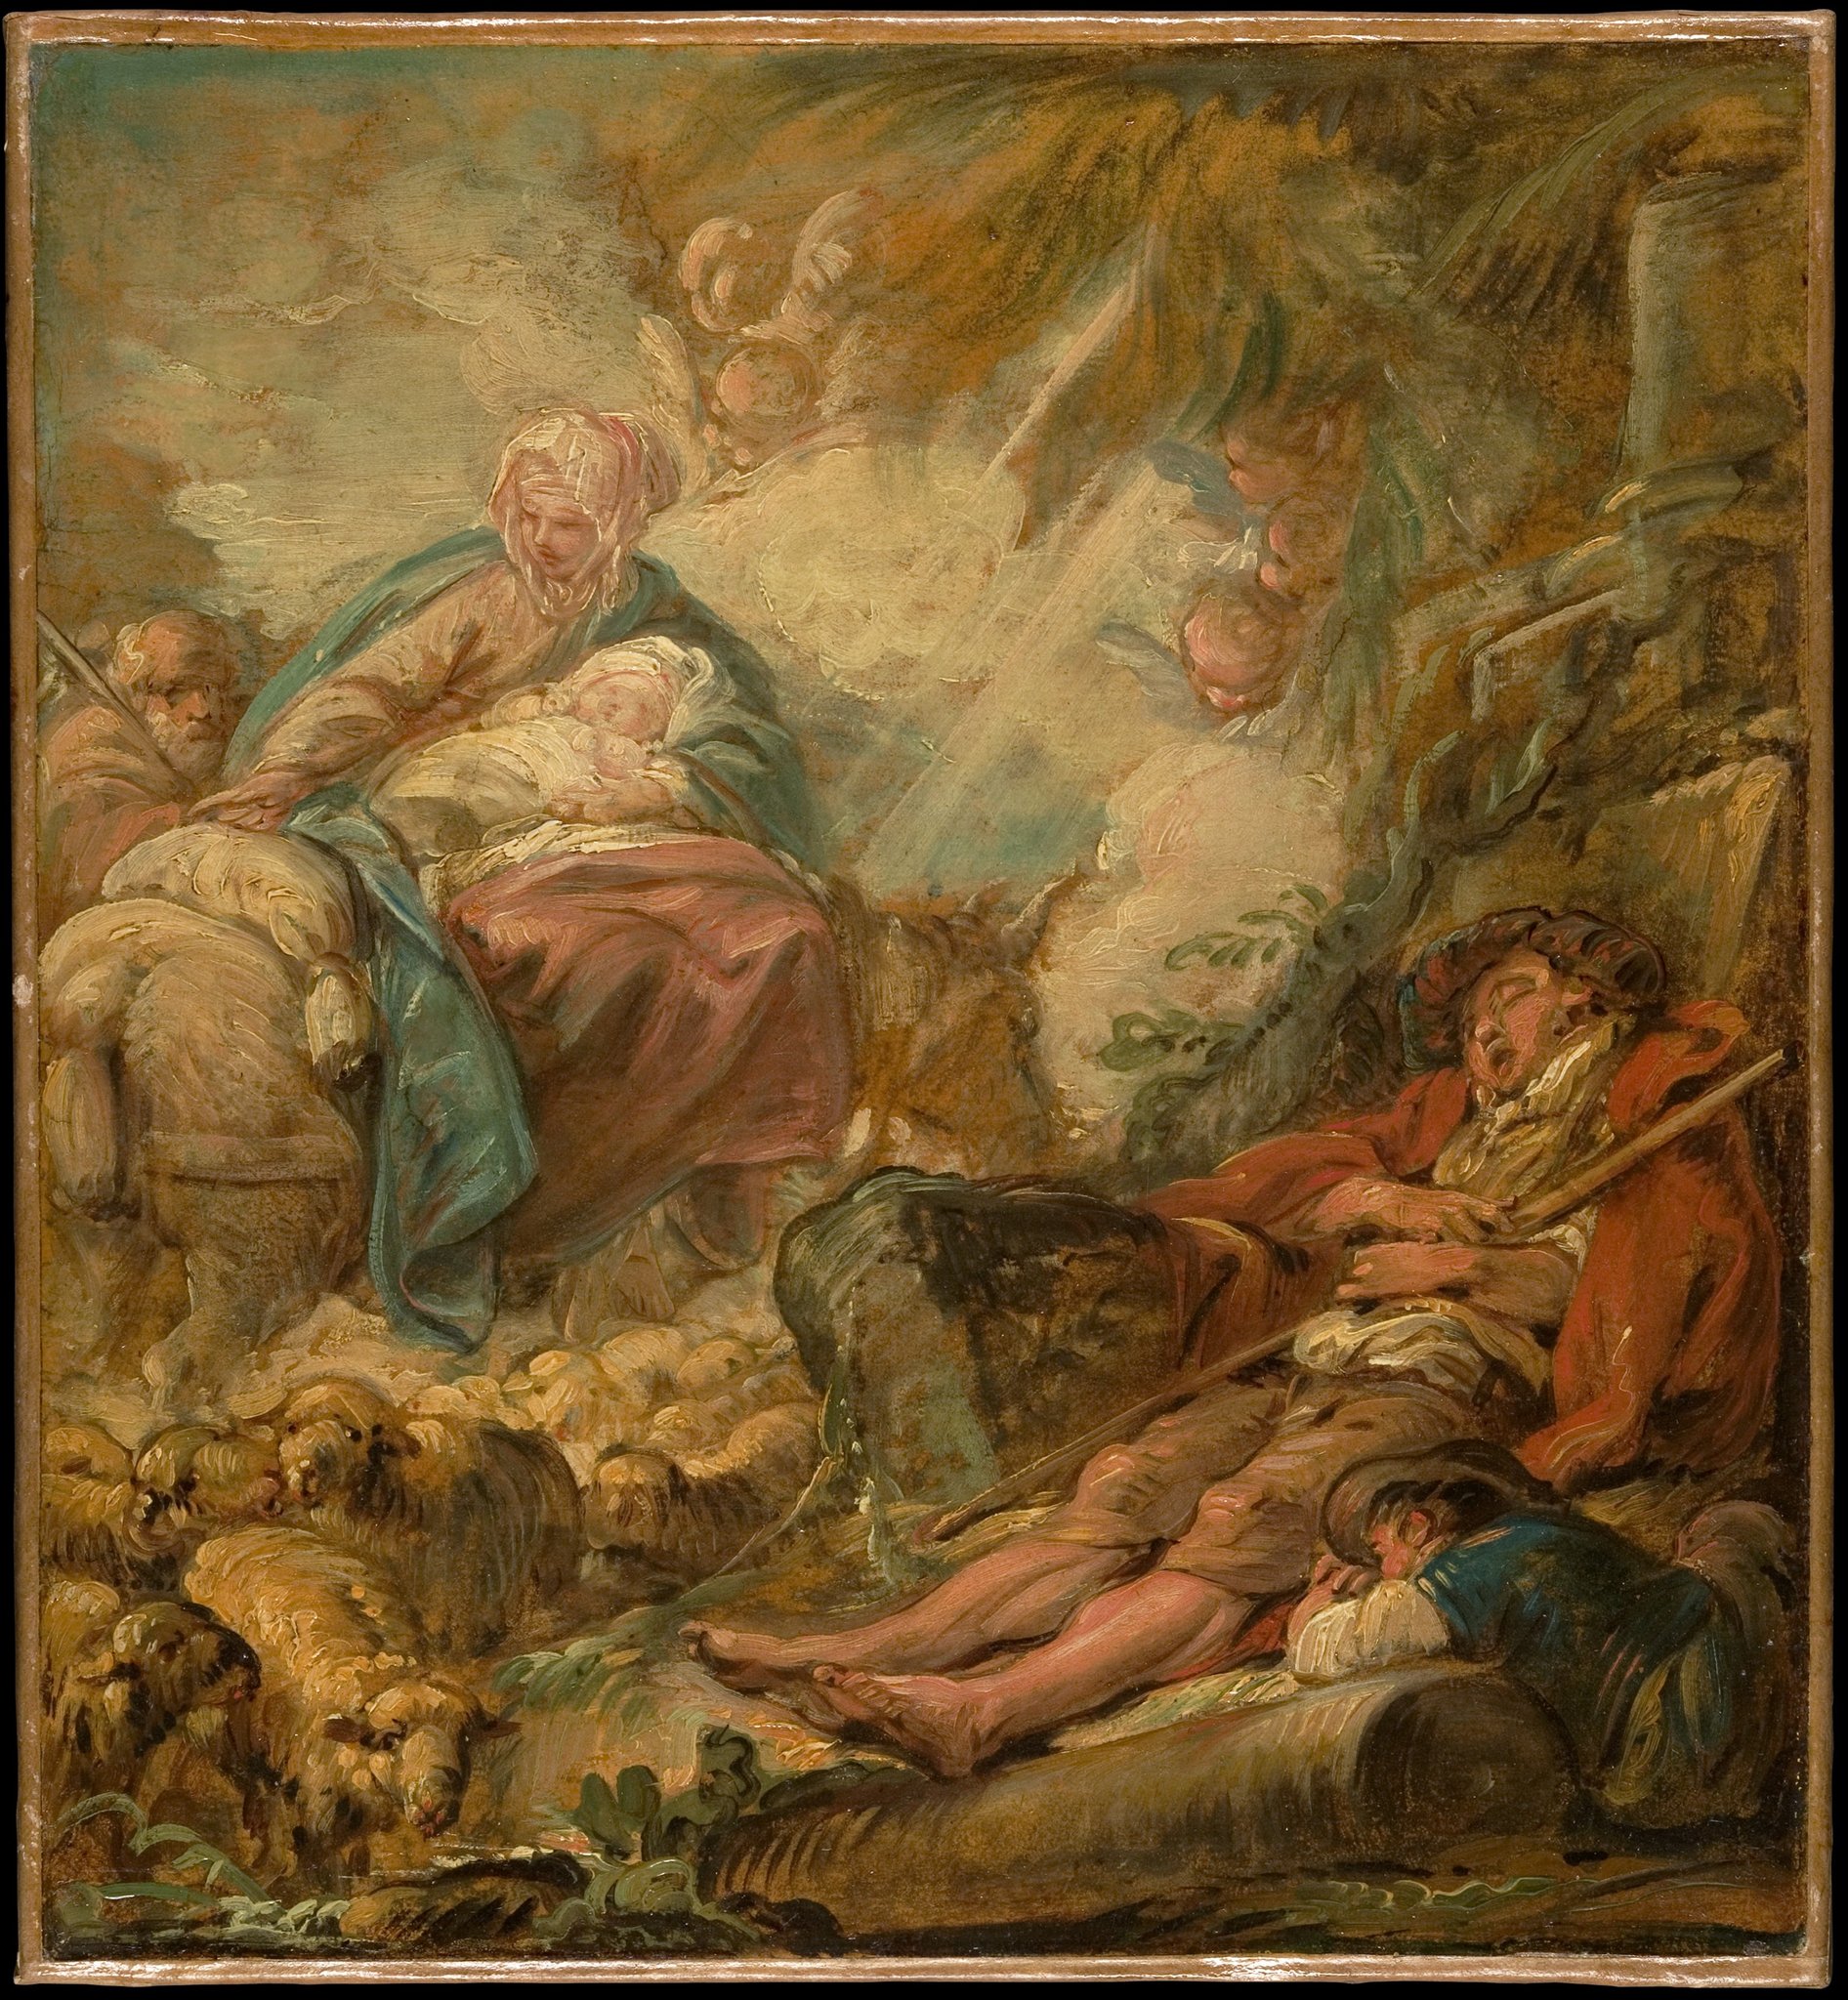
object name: drawing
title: Shepherds Dreaming of the Flight into Egypt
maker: jean-baptiste deshays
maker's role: artist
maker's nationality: french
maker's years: 1729-1765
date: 1701-1800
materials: canvas, chalk, oil, paper, varnish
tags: sleeping,men,women,sheep,shepherds